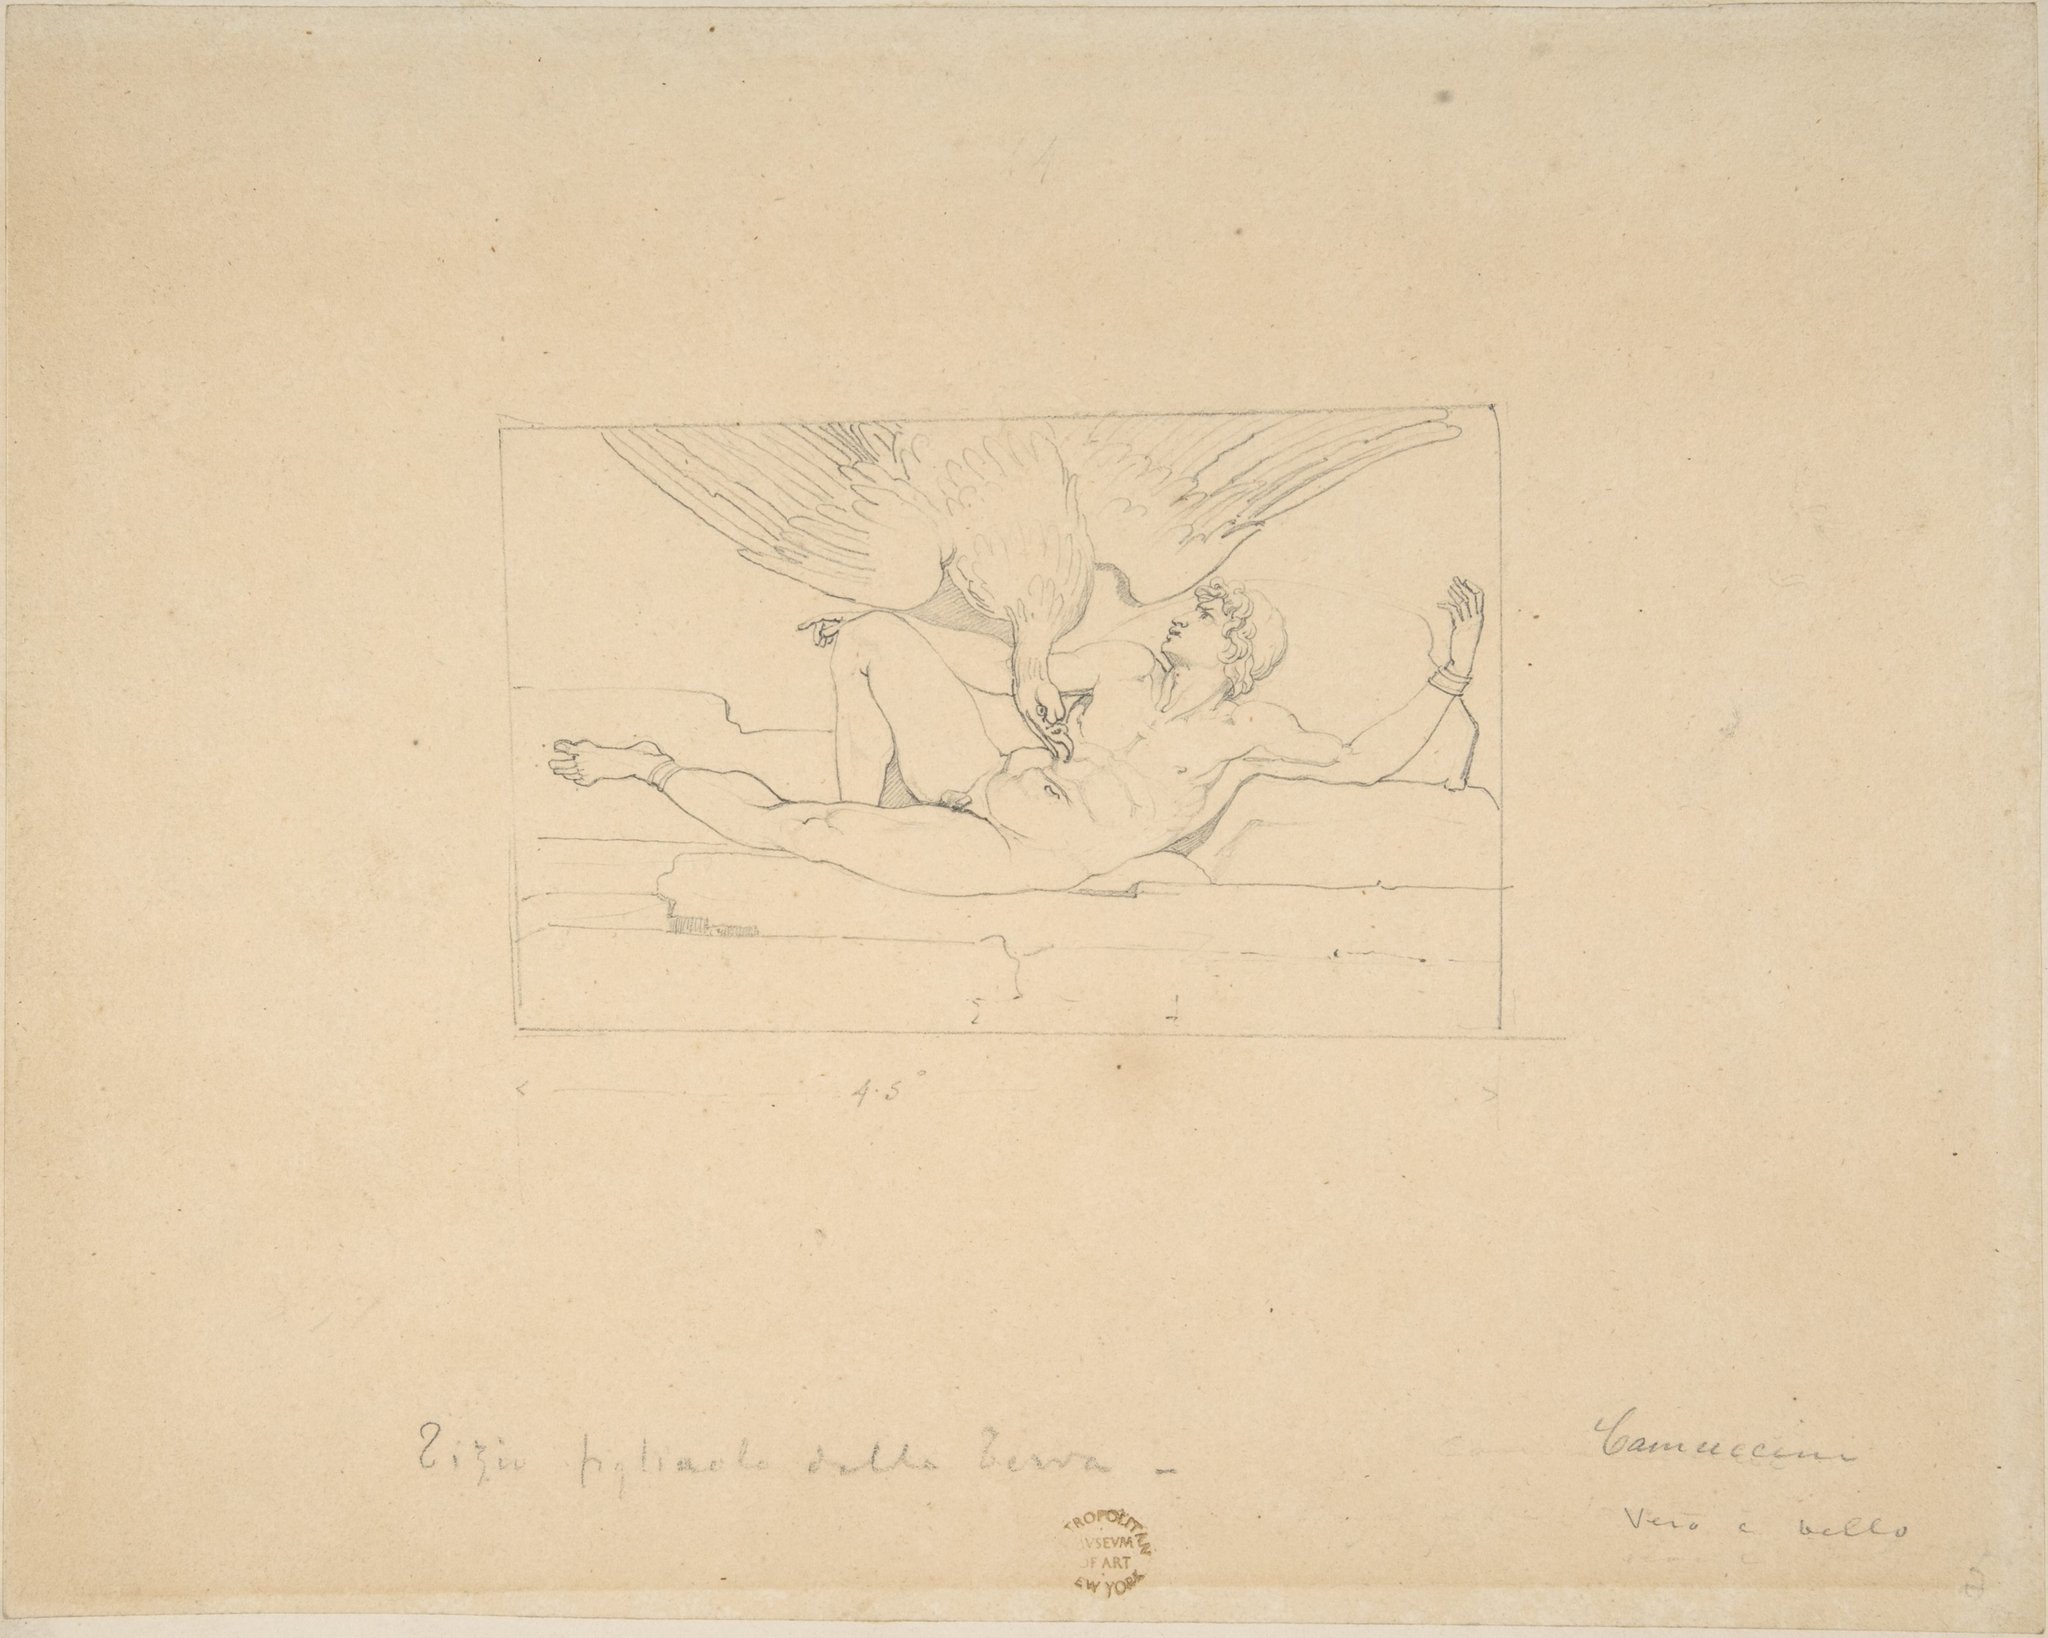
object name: drawing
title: Prometheus (or Tityus)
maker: vincenzo camuccini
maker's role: artist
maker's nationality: italian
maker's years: 1771-1844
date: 1795-1844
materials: graphite, lead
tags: birds,men